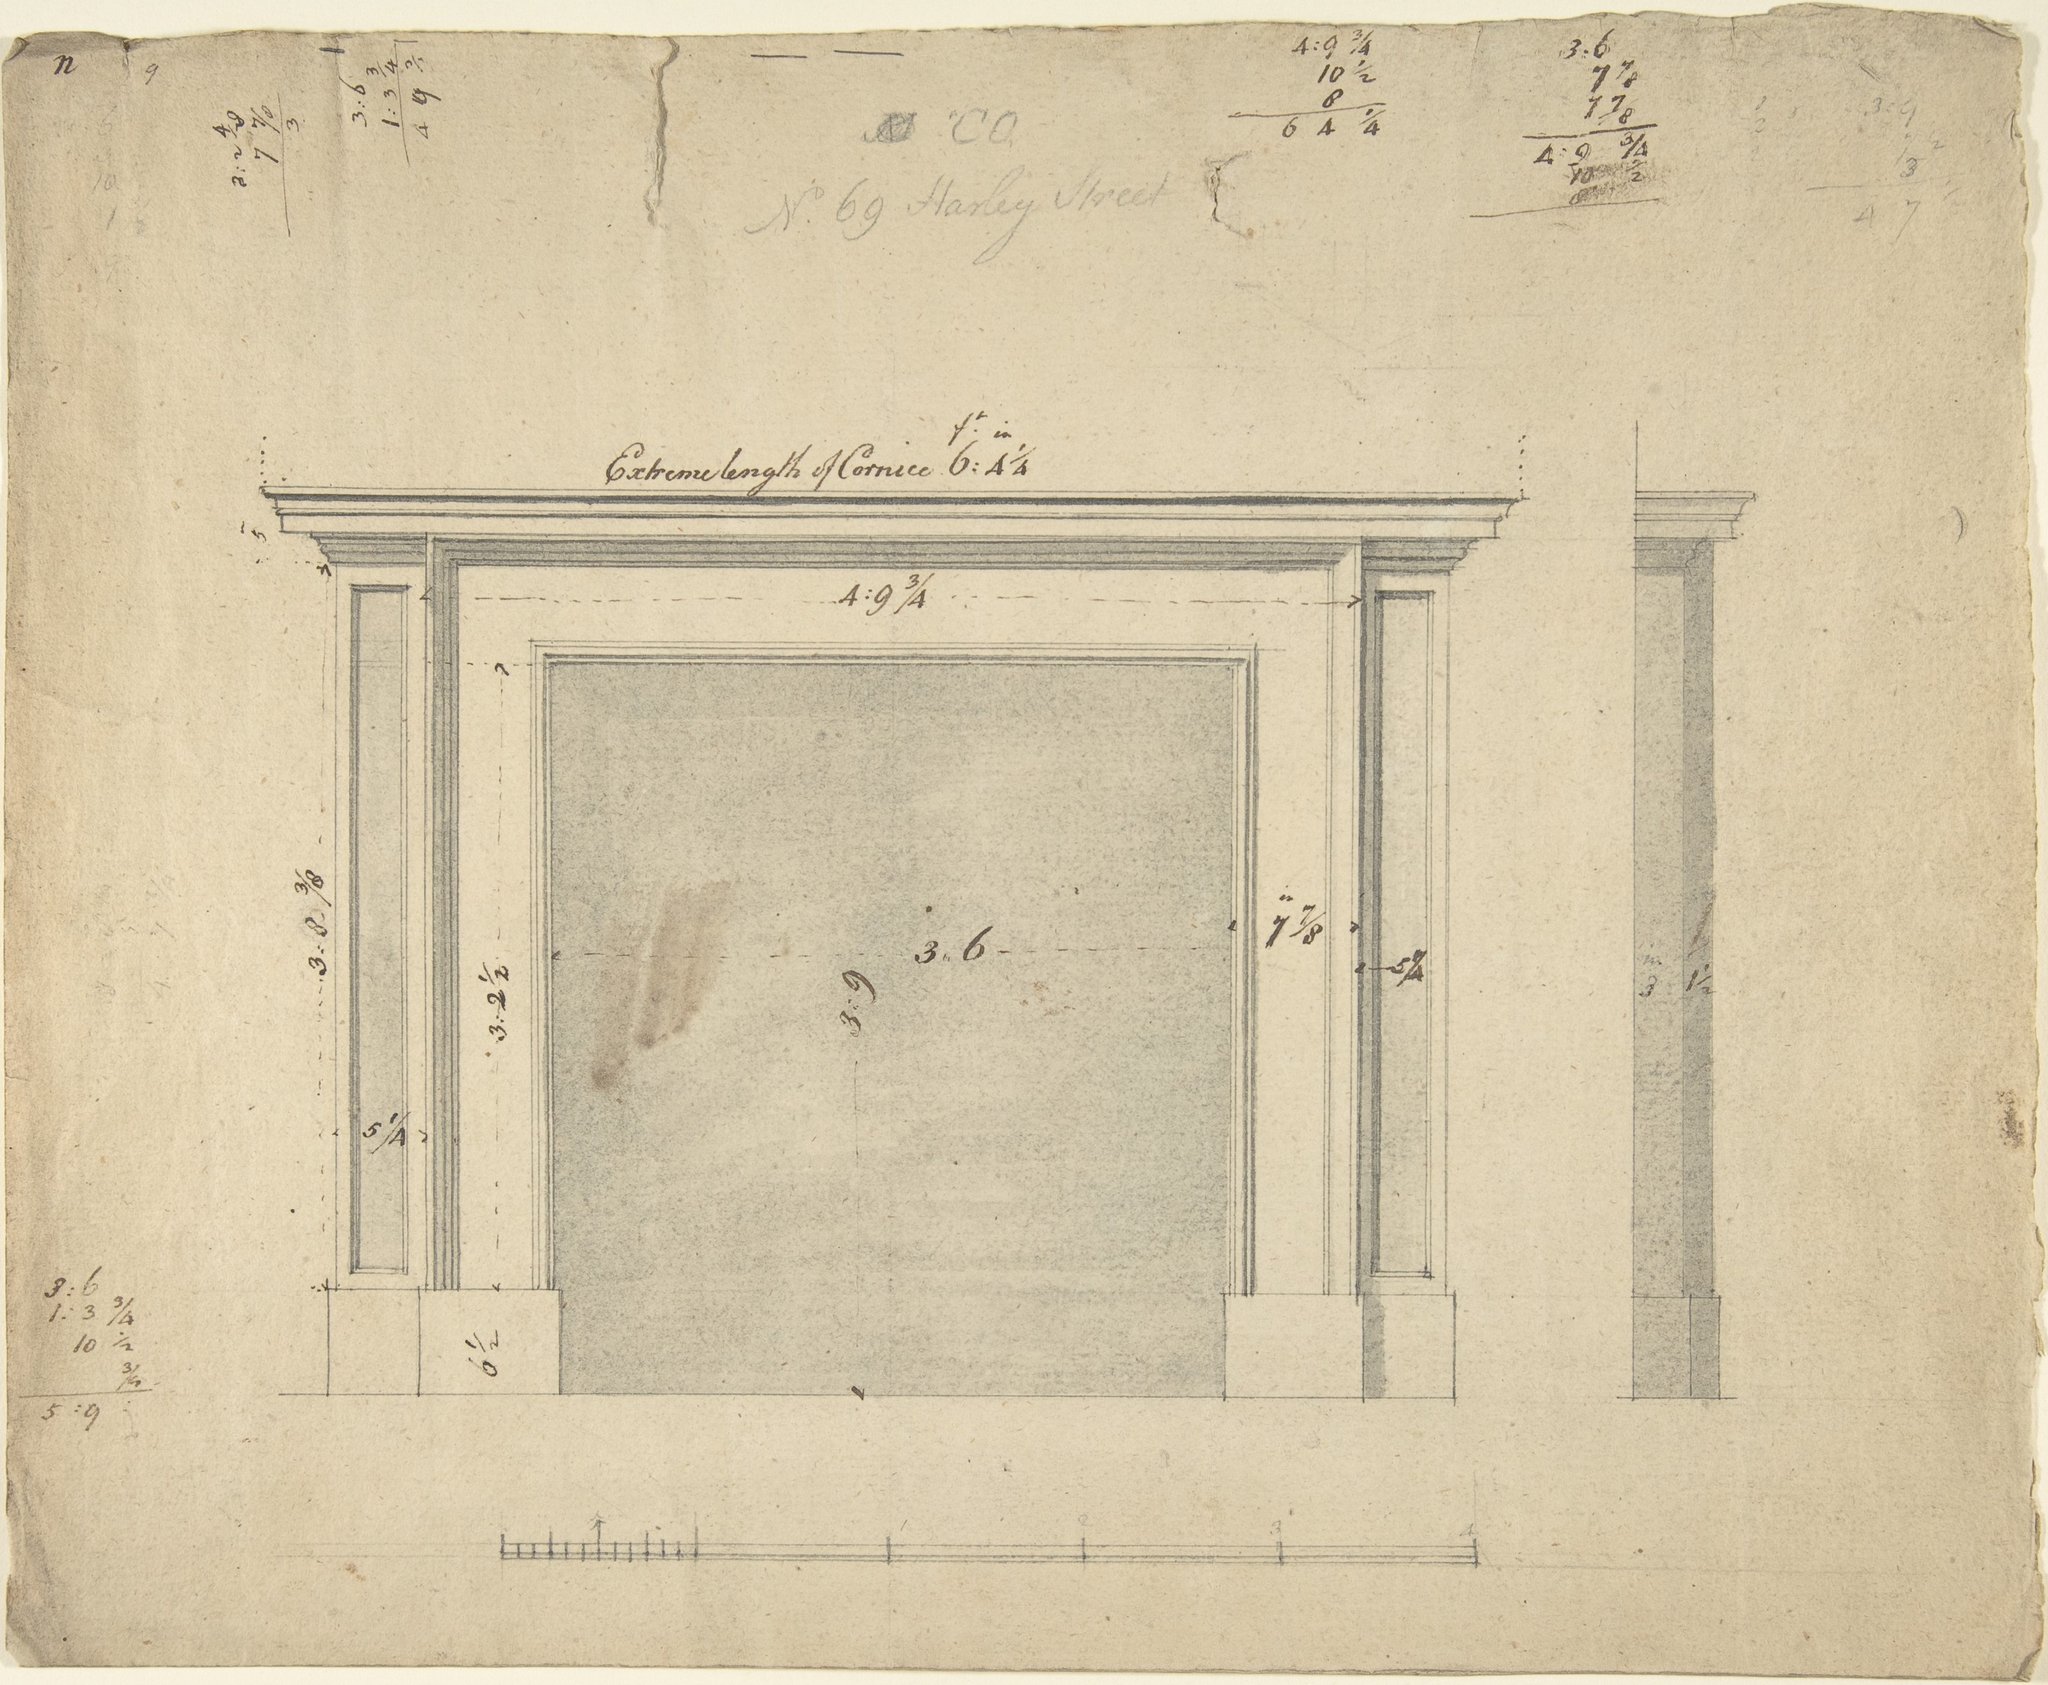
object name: drawing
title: Drawings for a Chimney-piece for 25 Harley Street, Westminster, London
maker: sir william chambers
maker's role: artist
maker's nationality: british, born sweden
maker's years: 1723-1796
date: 1740-1796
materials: ink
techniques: brush, pen, wash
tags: architecture